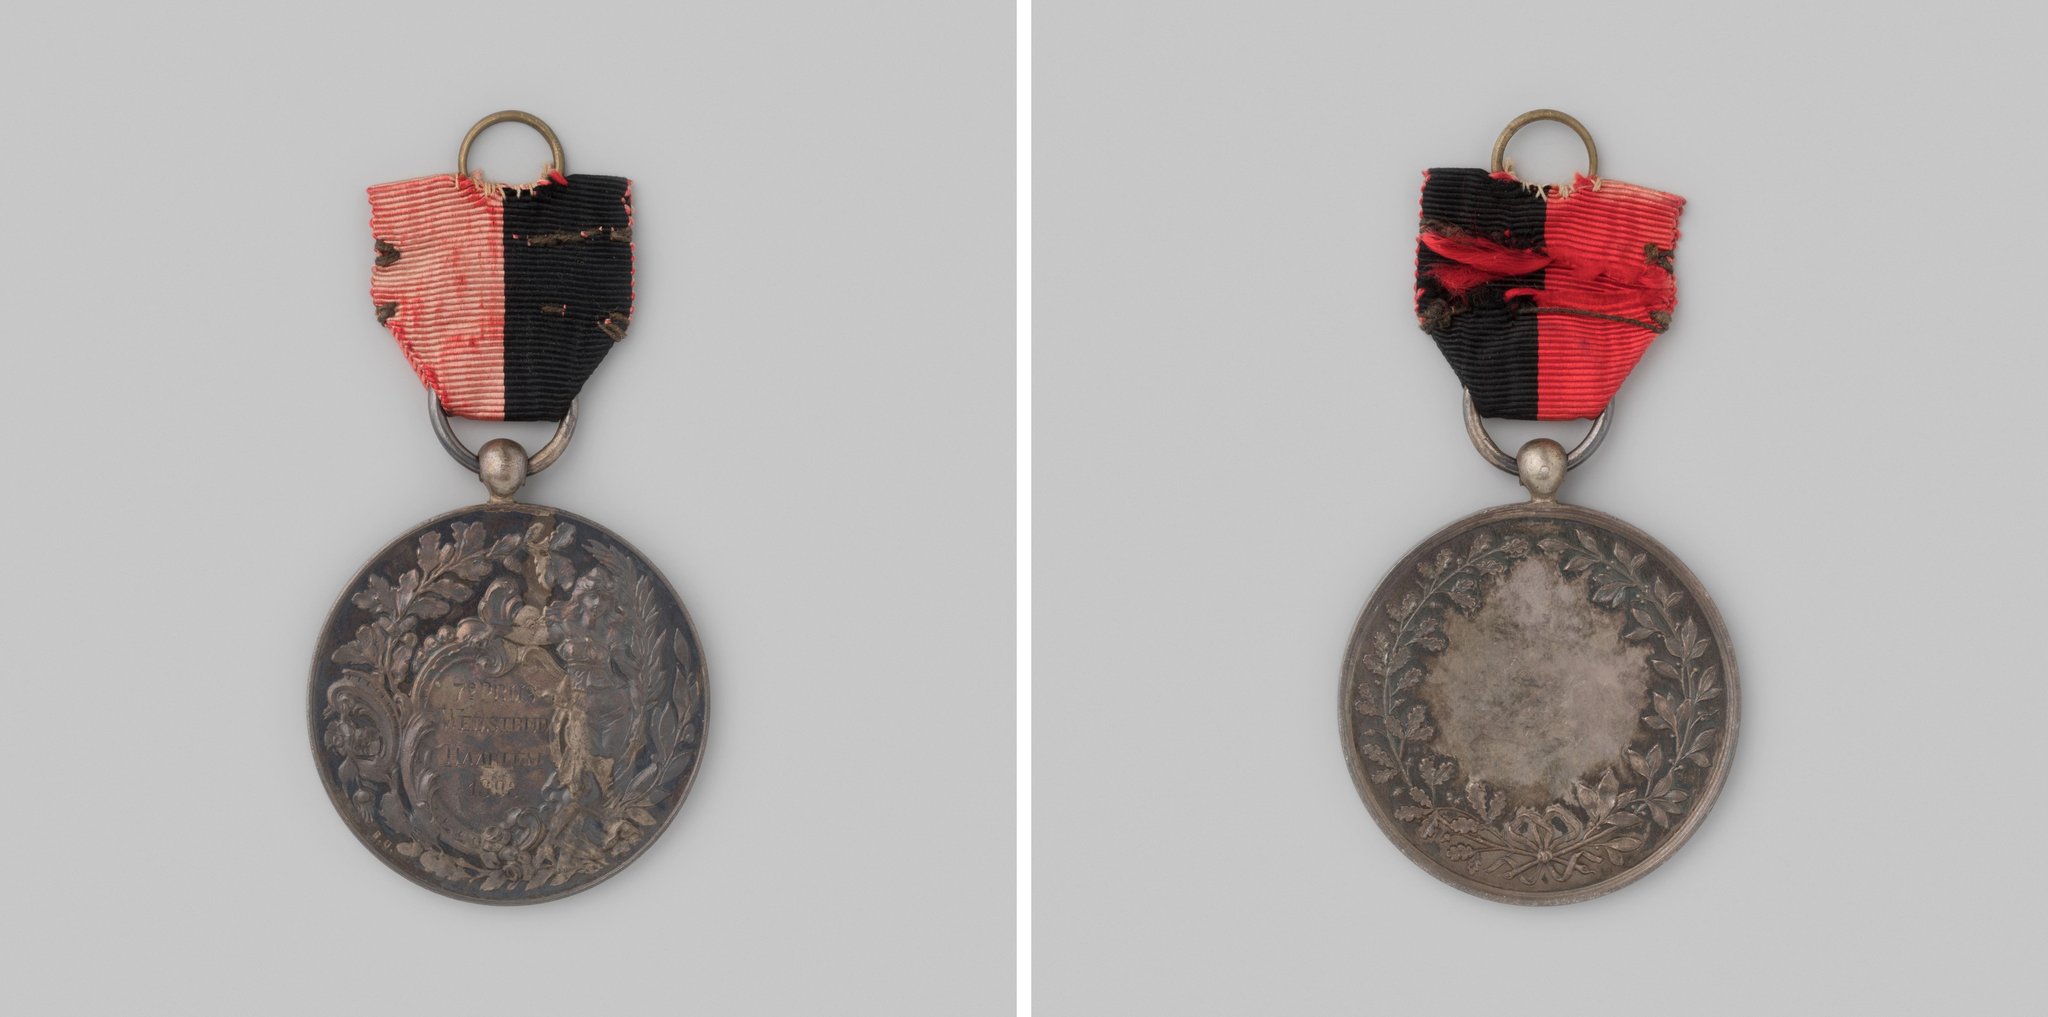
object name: medal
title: Prijspenning (handelspenning) uitgeloofd door de afdeling Generaal van Merle, Bond van Oud-Onderofficieren te Haarlem, behaald door de afdeling Amsterdam van de Nederlandsche Schutterij Kaderbond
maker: Anonymous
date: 1898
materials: metal, textile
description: Metalen draagpenning met knop, ring en lint.